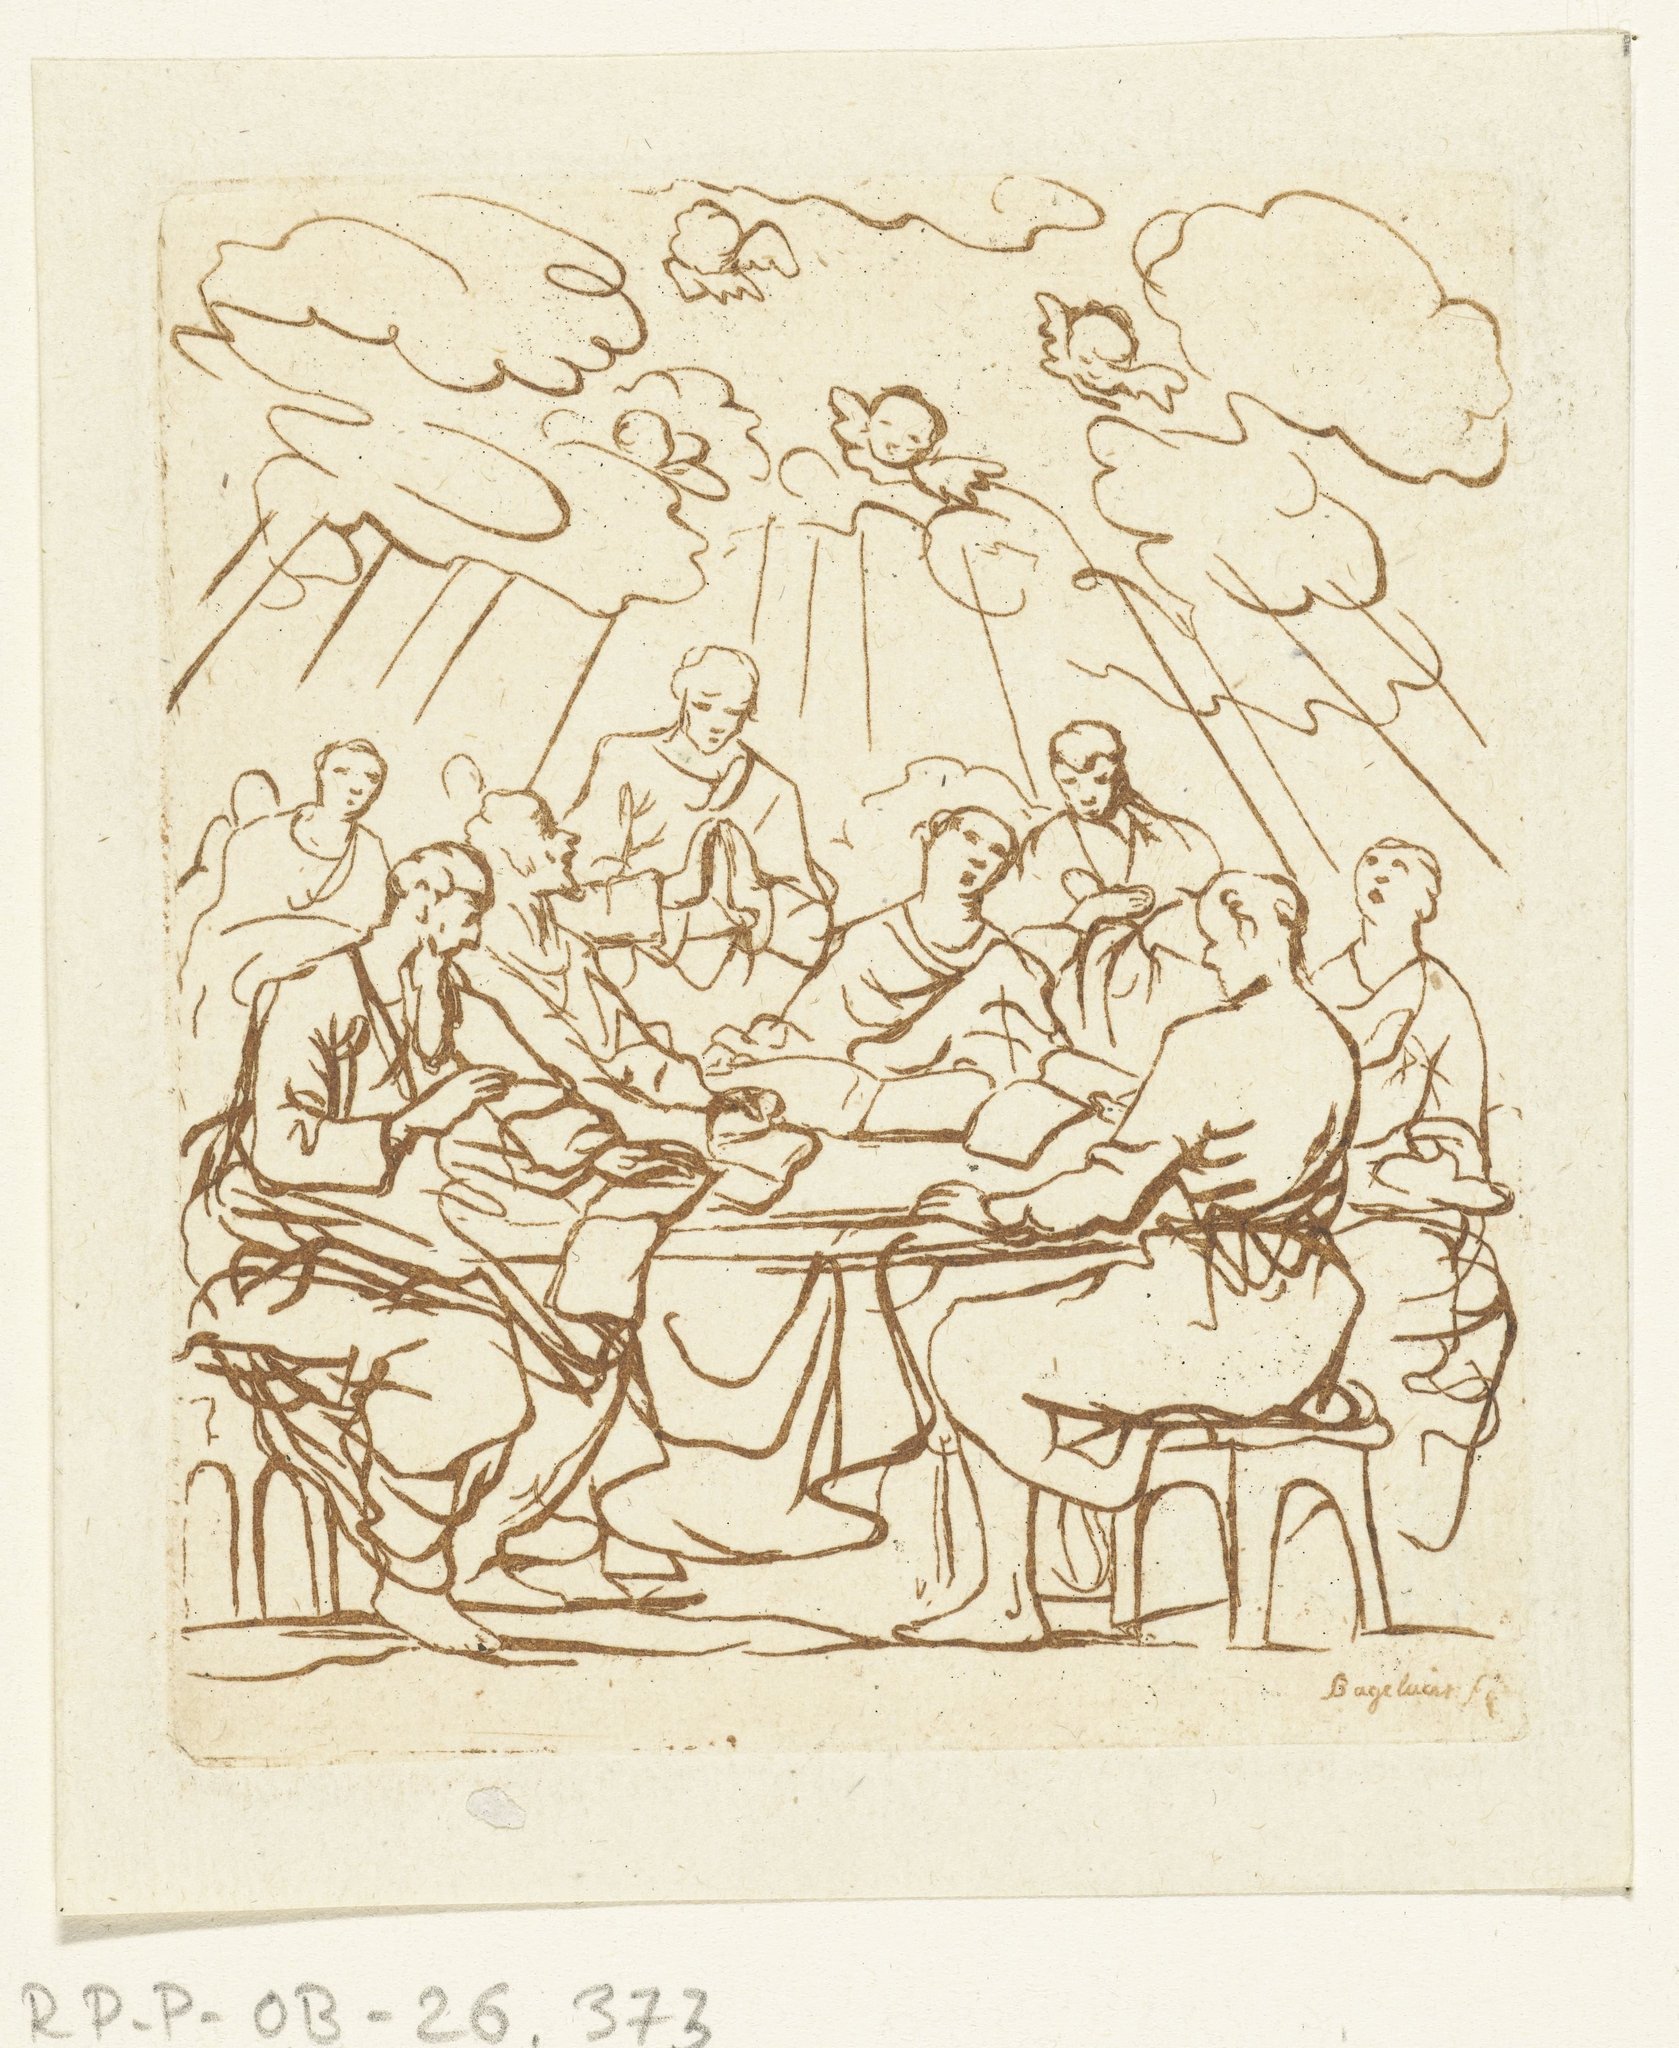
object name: print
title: Een gezelschap van acht lofzingende personen rondom een tafel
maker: ernst willem jan bagelaar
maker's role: draughtsman, print maker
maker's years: 1775-1837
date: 1798-1837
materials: paper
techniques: etching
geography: netherlands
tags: (public) prayer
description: naar een tekening in het Amsterdams Historisch Museum inv. no. TA13918